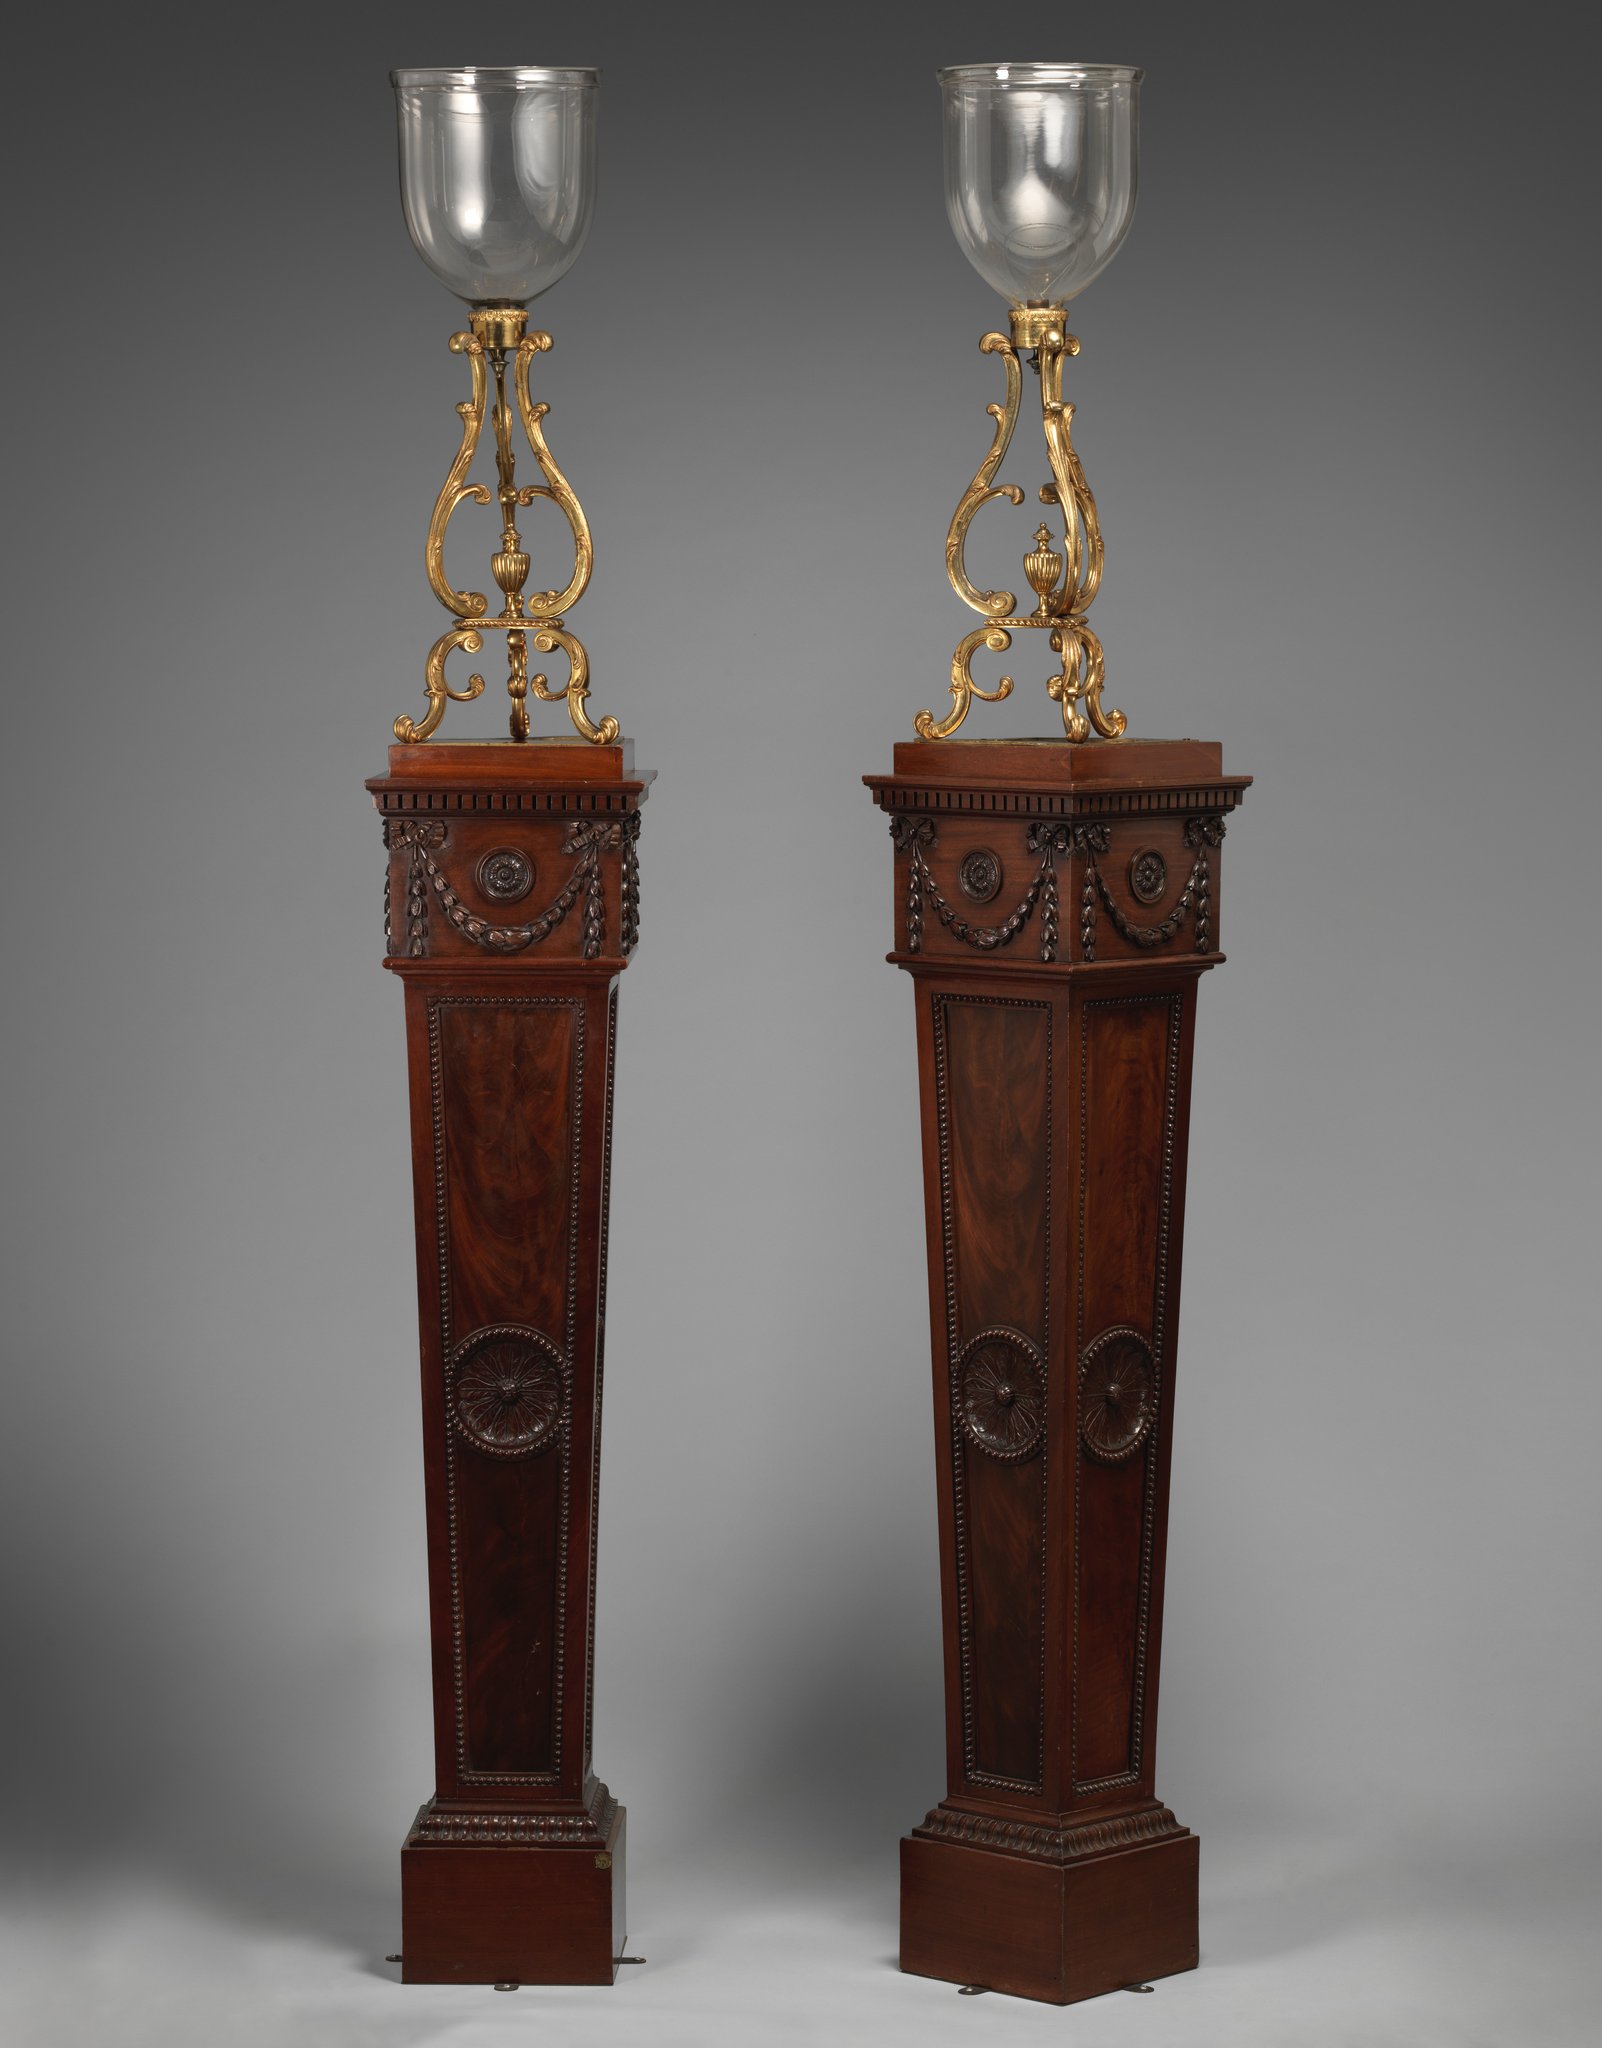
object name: pedestal with candleholder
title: Pedestal with candleholder (one of a pair)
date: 1775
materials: brass, glass, wood